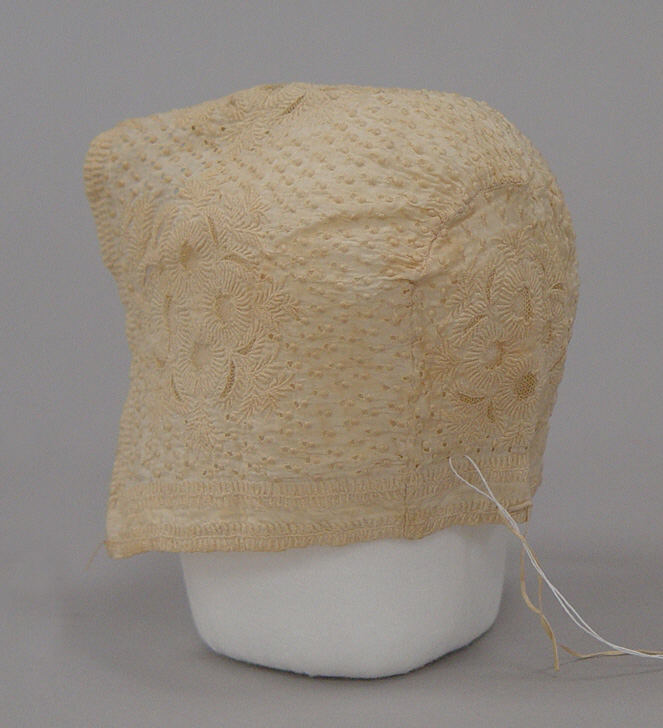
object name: cap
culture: american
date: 1800-1825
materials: cotton